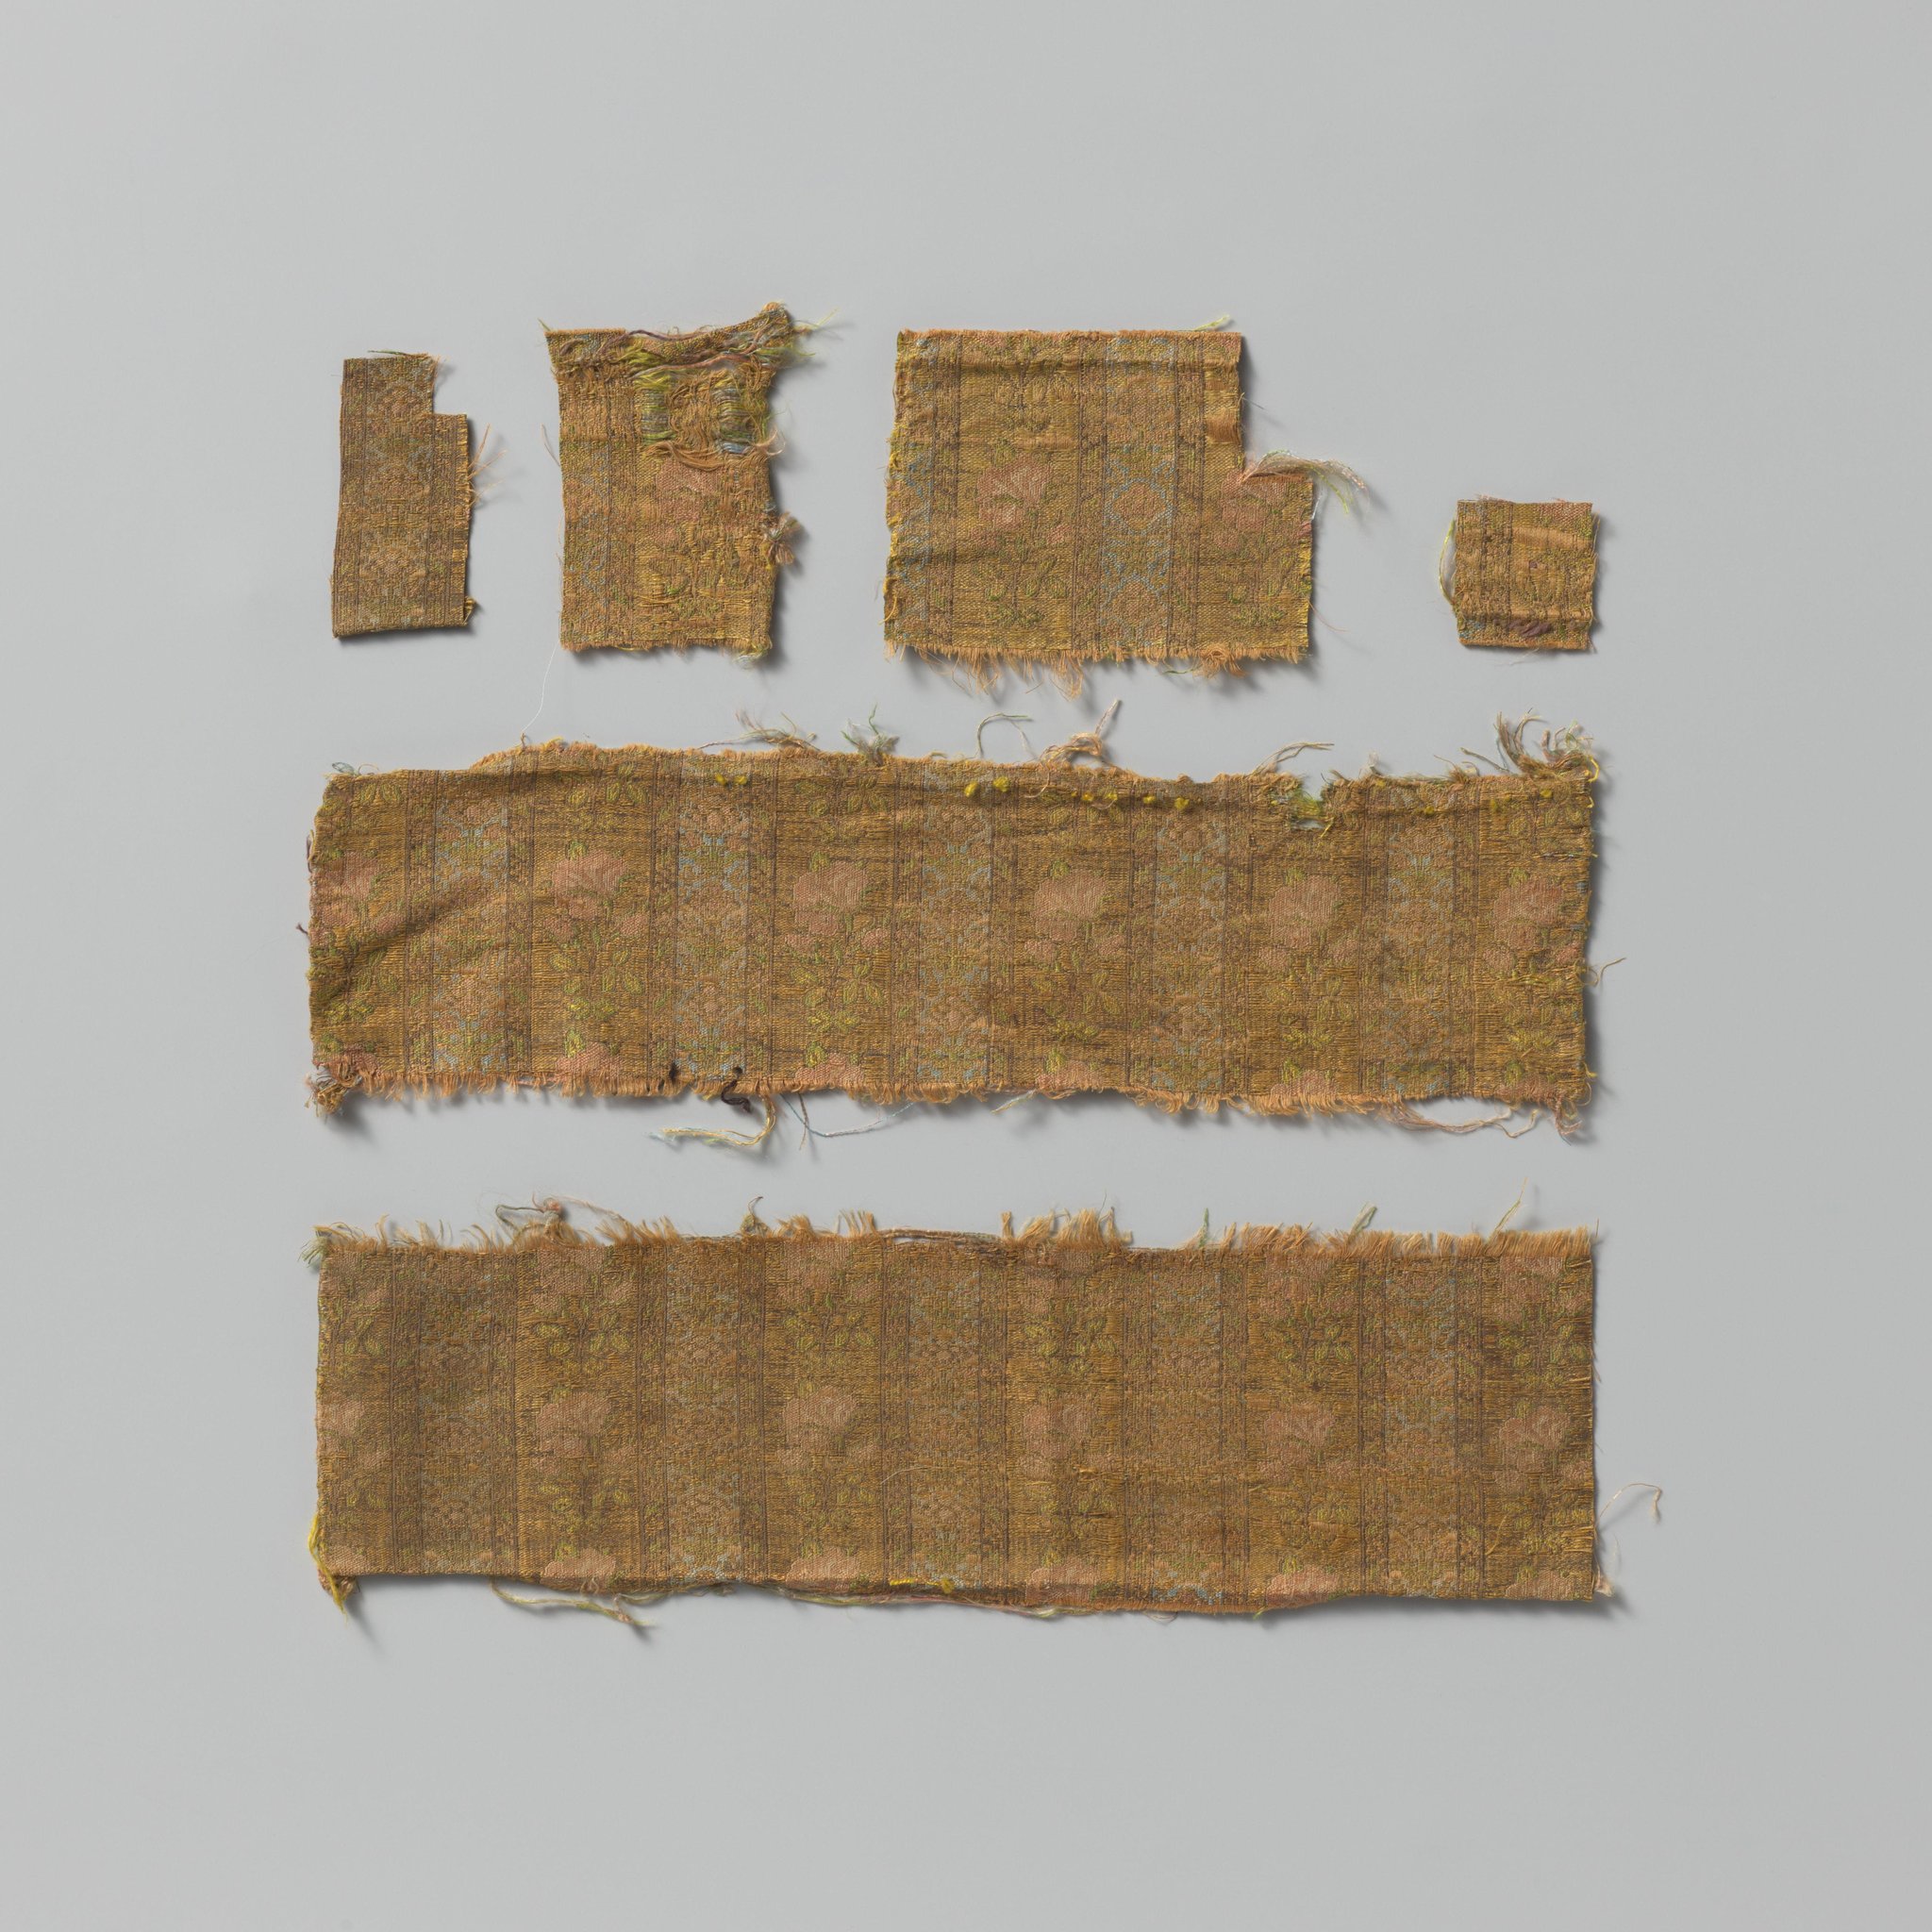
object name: zijdebrokaat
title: Fragment zijden brokaatweefsel met een patroon van pastelkleurige bloemen op gestreepte grond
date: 1600-1800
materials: silk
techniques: brocade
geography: iran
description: Fragment zijden brokaatweefsel met een patroon van pastelkleurige bloemen op gestreepte grond. Patroon: verticale zilveren banen (vergaan tot op de gele kern) afgewisseld met smalle lichtblauwe banen in grijs-beige lijstwerk. Vulling van gebogen bloemtakken en stijve palmetbloemen in roze met wit en roze met zilver. Oosters textiel.